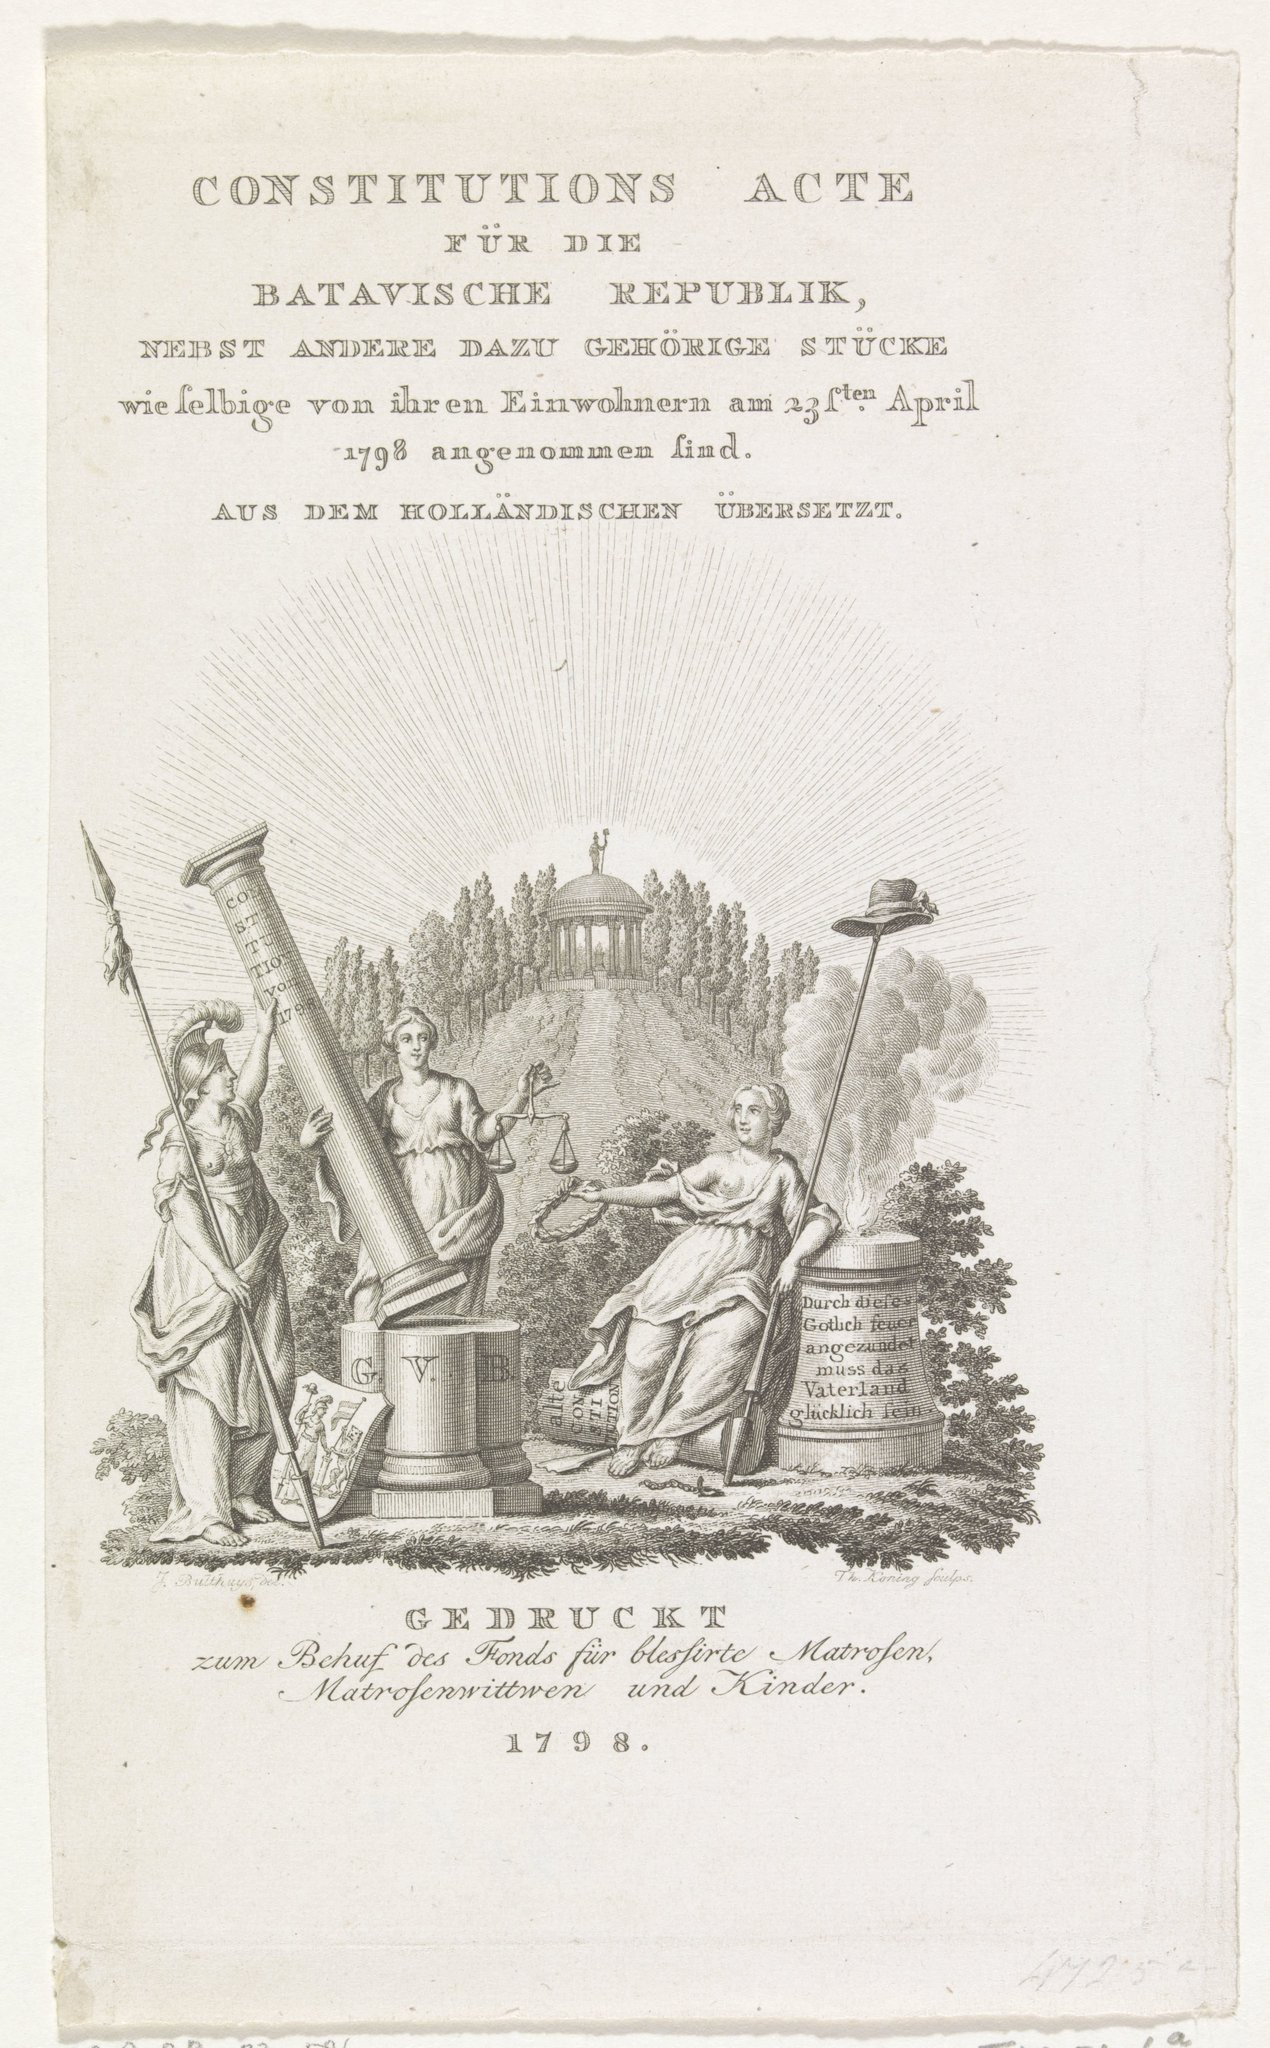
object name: print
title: Titelblad voor: Constitutions-Acte für die Batavische Republik, nebst andere dazu gehörige Stücke wie selbige von ihren Einwohnern am 23 April 1798 angenommen sind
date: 1798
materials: paper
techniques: engraving, etching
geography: netherlands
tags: justice, 'justitia'; 'giustitia divina' (ripa) ~ one of the four cardinal virtues, personifications of countries, nations, states, districts, etc., (story of) minerva (pallas, athena), freedom, liberty; 'libertà' (ripa) (+ abstract concept represented by female figure), netherlands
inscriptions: collector's mark: Lugt 2166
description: Gegraveerd titelblad voor een Duitse vertaling van de grondwet van de Bataafse Republiek. Justitia en Minerva plaatsen de zuil der constitutie van 1798 op het voetstuk Vrijheid, Gelijkheid en Broederschap, met rechts de Nederlandse Maagd met de vrijheidshoed op een speer. Op de achtergrond een tempel op een heuvel.